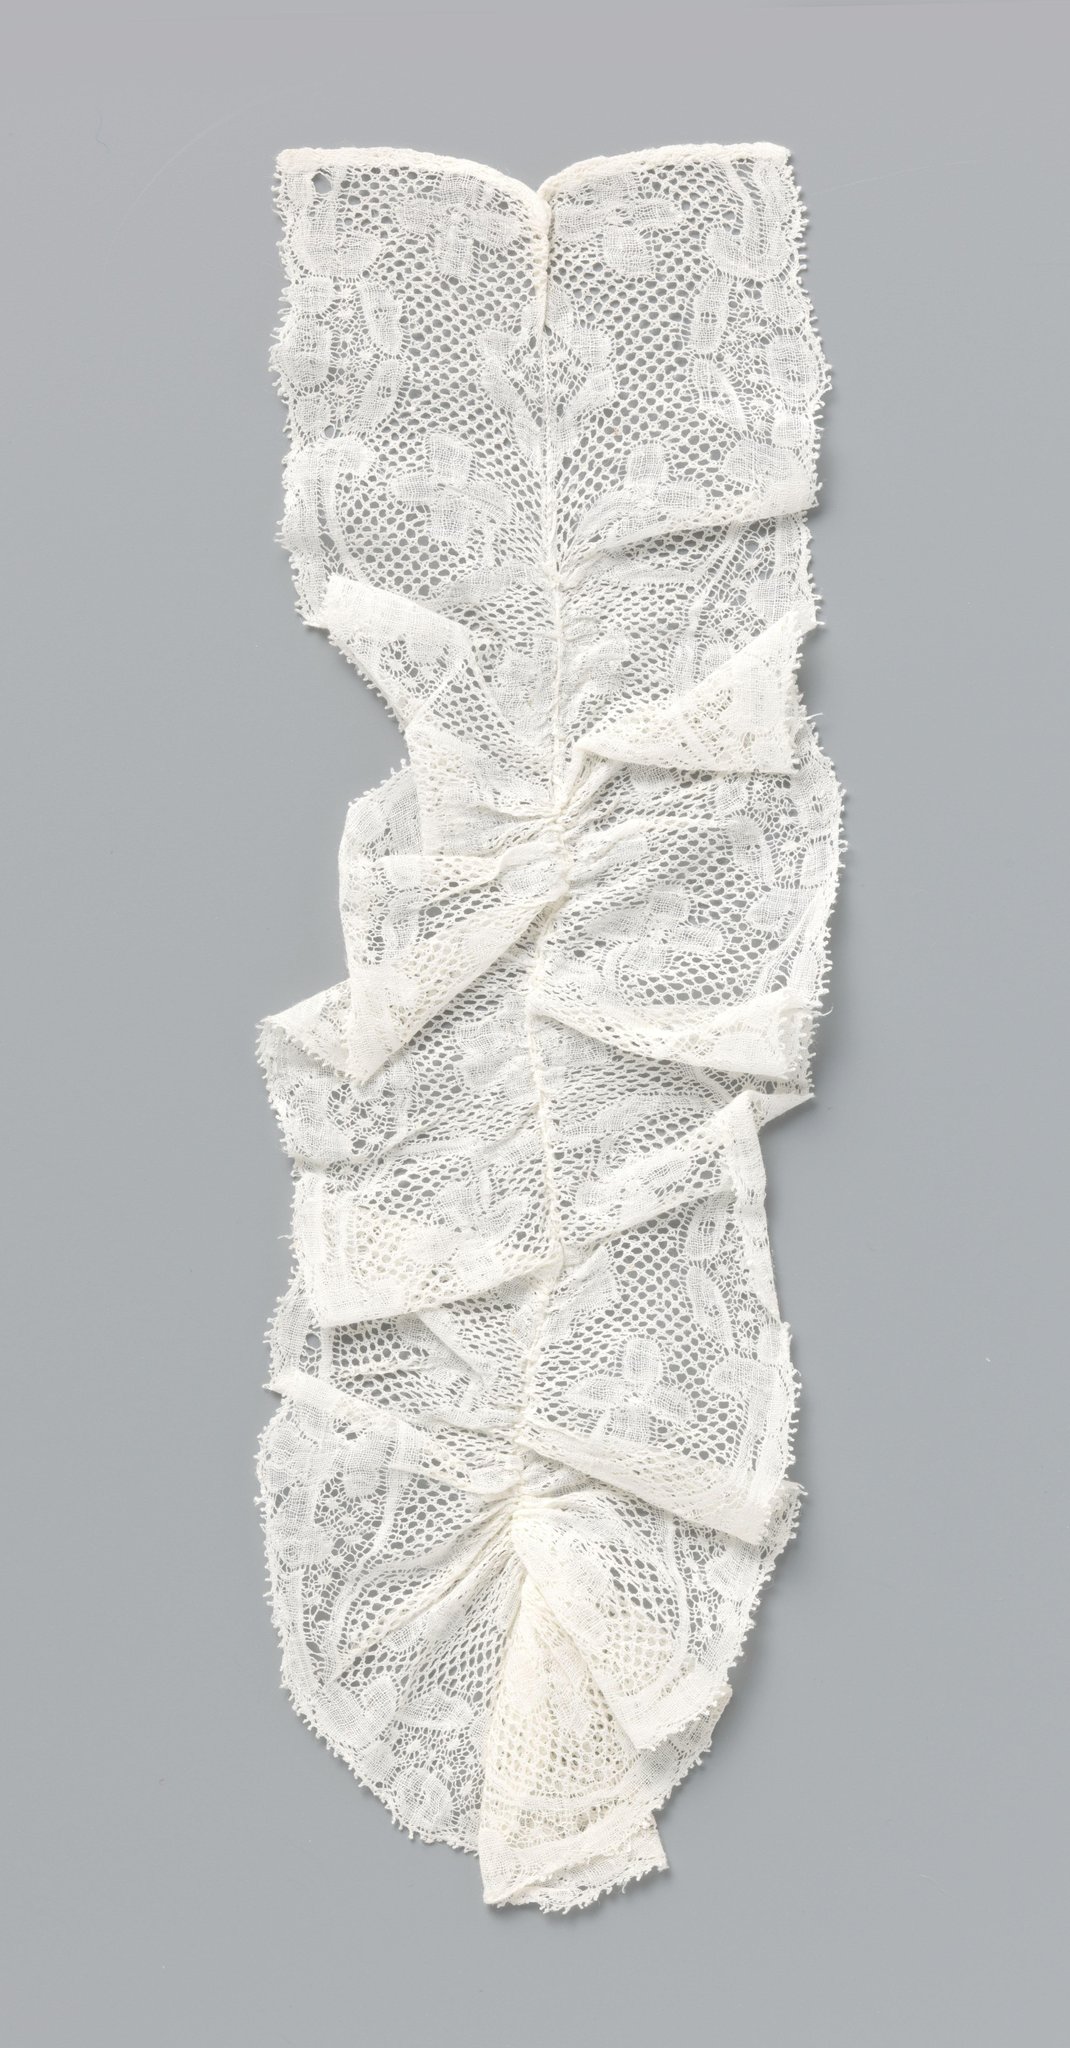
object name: childrenswear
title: Jabot van kloskant voor kind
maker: Anonymous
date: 1760-1780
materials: lace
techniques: lace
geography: binche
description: Jabot van kloskant voor kind. Het patroon heeft langgerekte, flauwe schulpen met ovale reserves en spiraalranken. Daartegenover gehalveerde (door een naald tussen twee stroken tot een geheel worden) medaillons en gelobde bloemen.